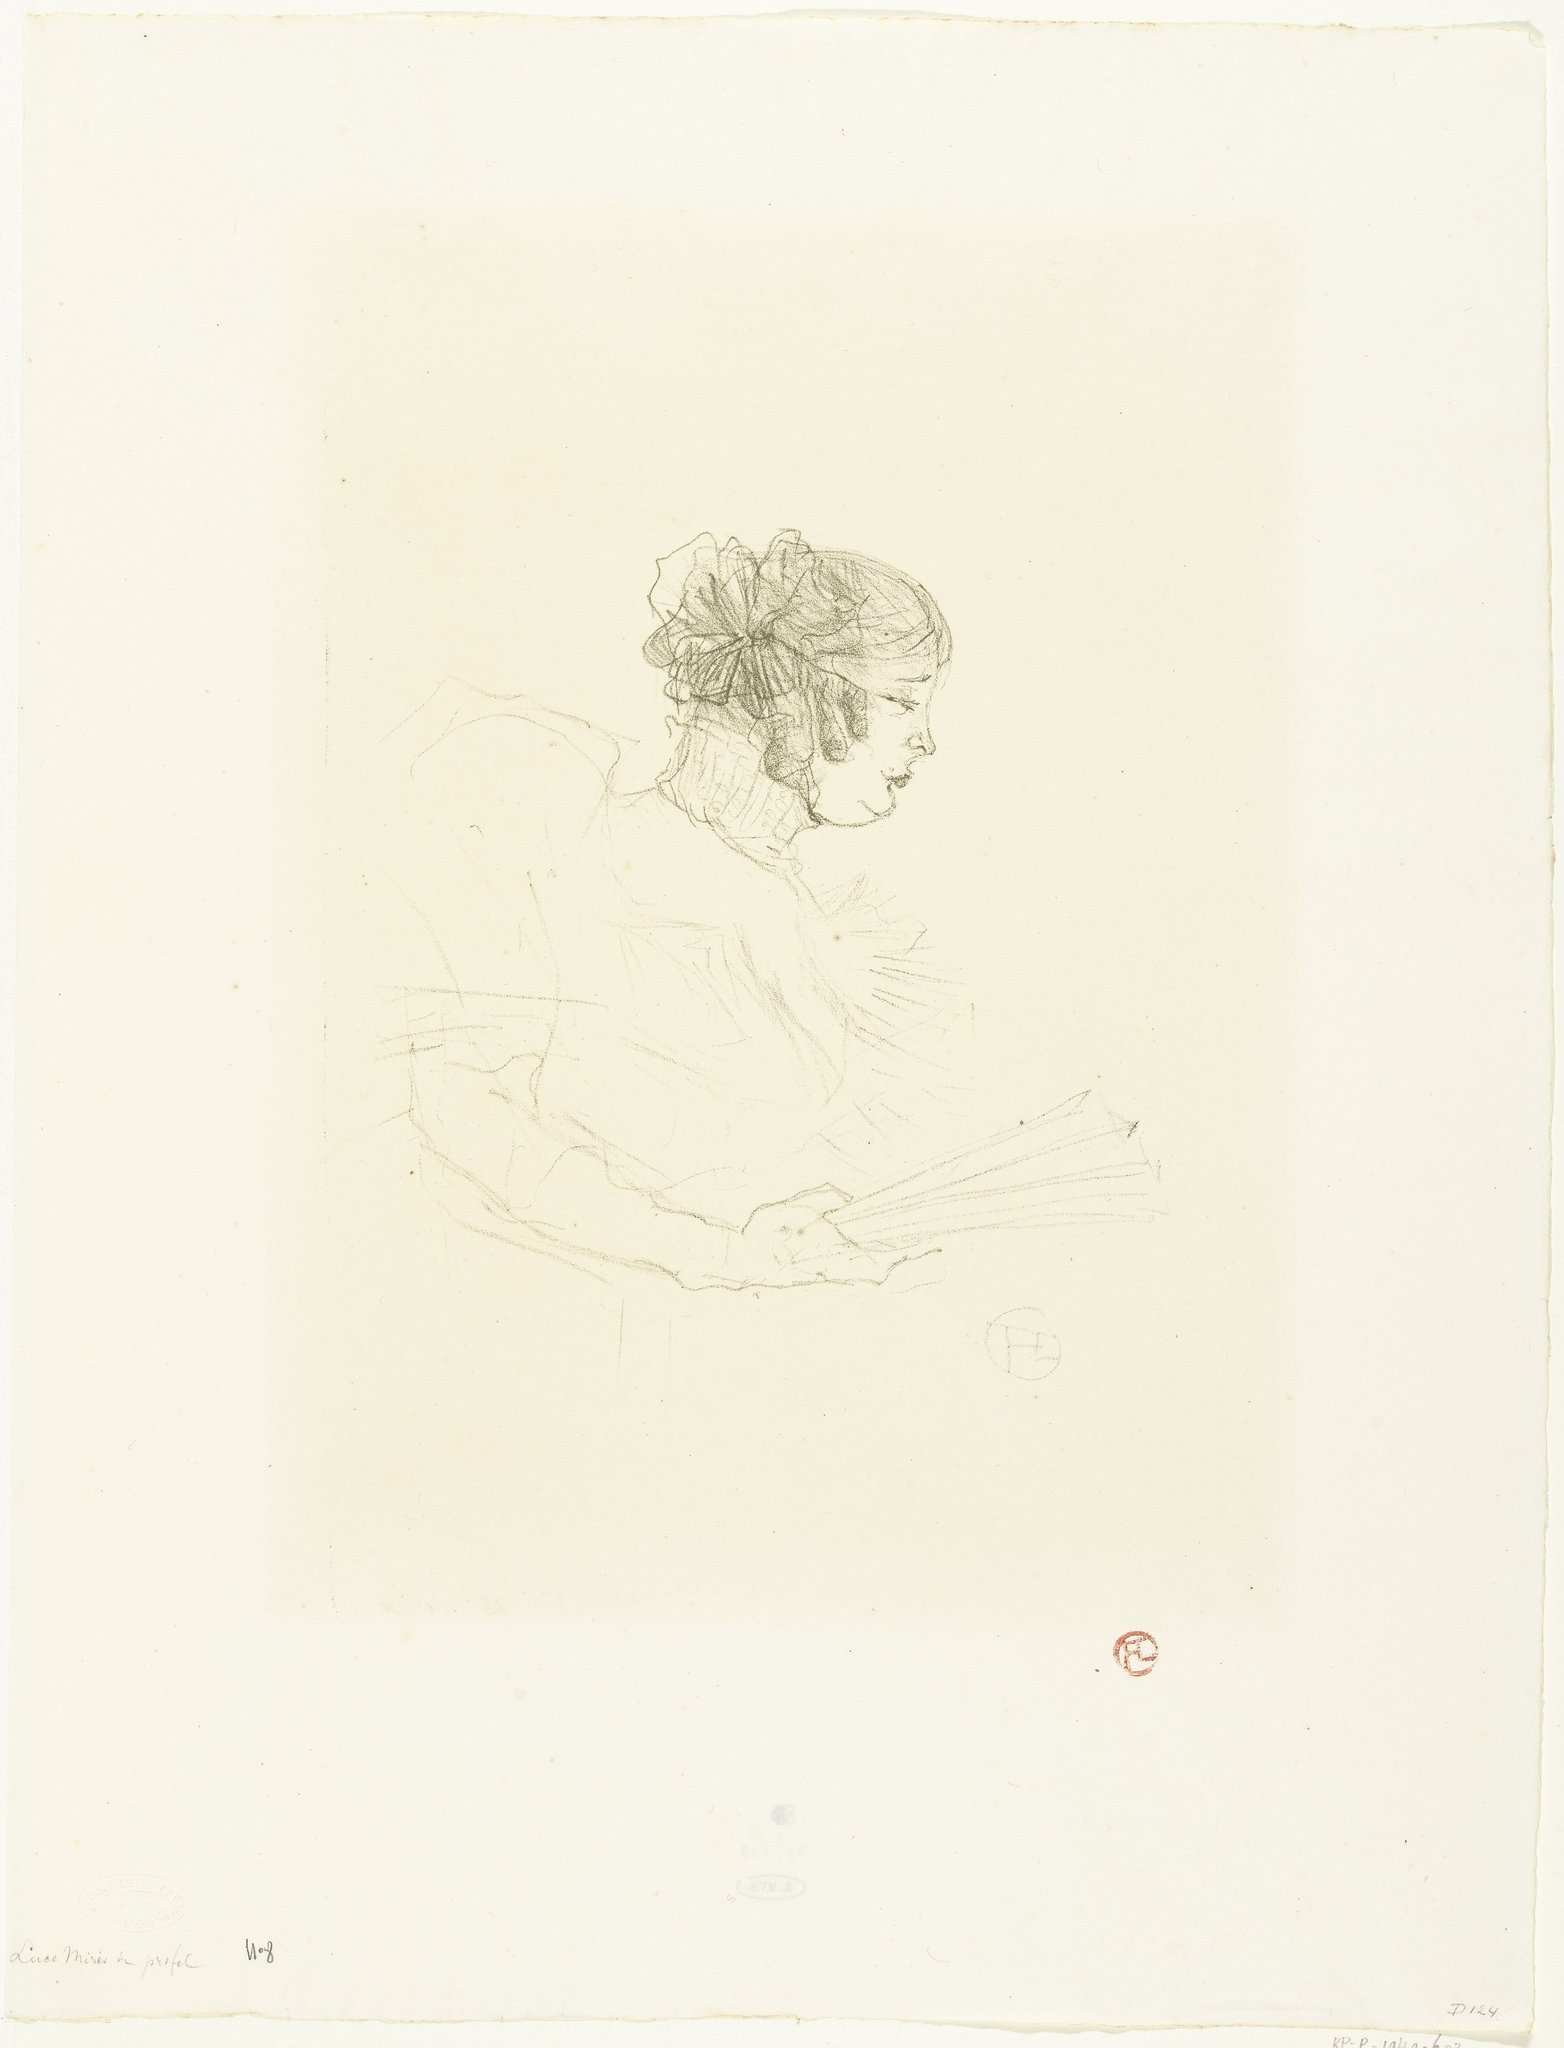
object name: print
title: Portret van actrice Luce Myrès met waaier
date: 1895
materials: paper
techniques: printing, lithograph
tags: actress (on the stage)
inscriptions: stamp: Lugt 1338, collector's mark: Lugt 2228, check stamp: Lugt 1573, collector's mark: Lugt 2760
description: Verschenen in oplage van circa dertig exemplaren.